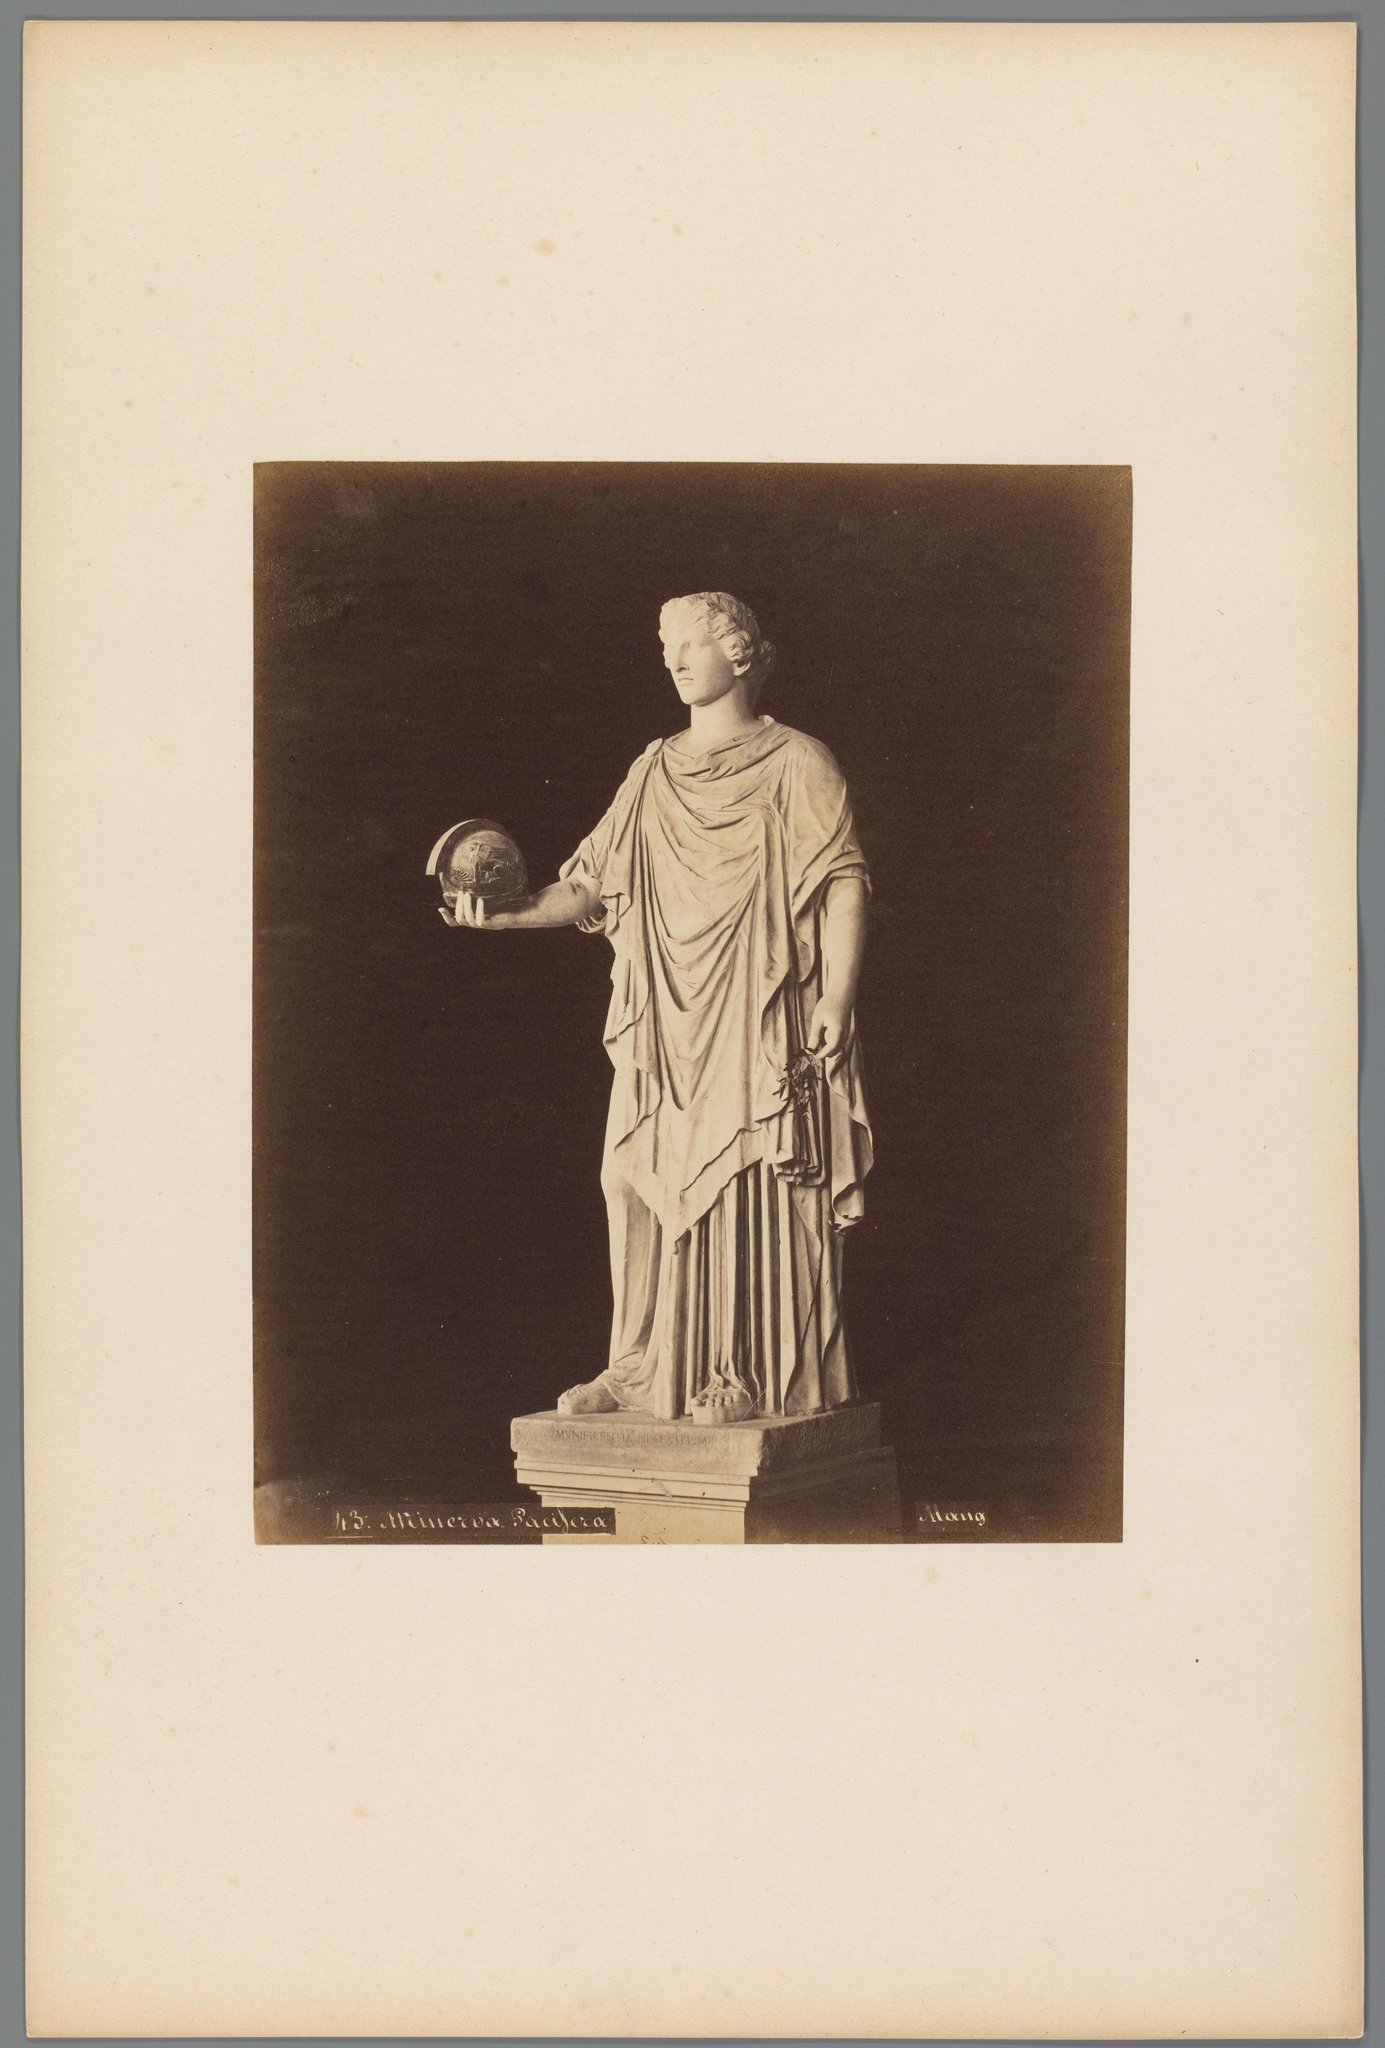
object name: photograph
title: Sculptuur van Minerva Pacifera in de Vaticaanse Musea, Italië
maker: michèle mang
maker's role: fotograaf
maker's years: 1840-1909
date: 1863-1887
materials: cardboard, paper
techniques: albumen print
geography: vatican city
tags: (story of) minerva (pallas, athena), piece of sculpture, reproduction of a piece of sculpture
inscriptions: number: ‘43.’